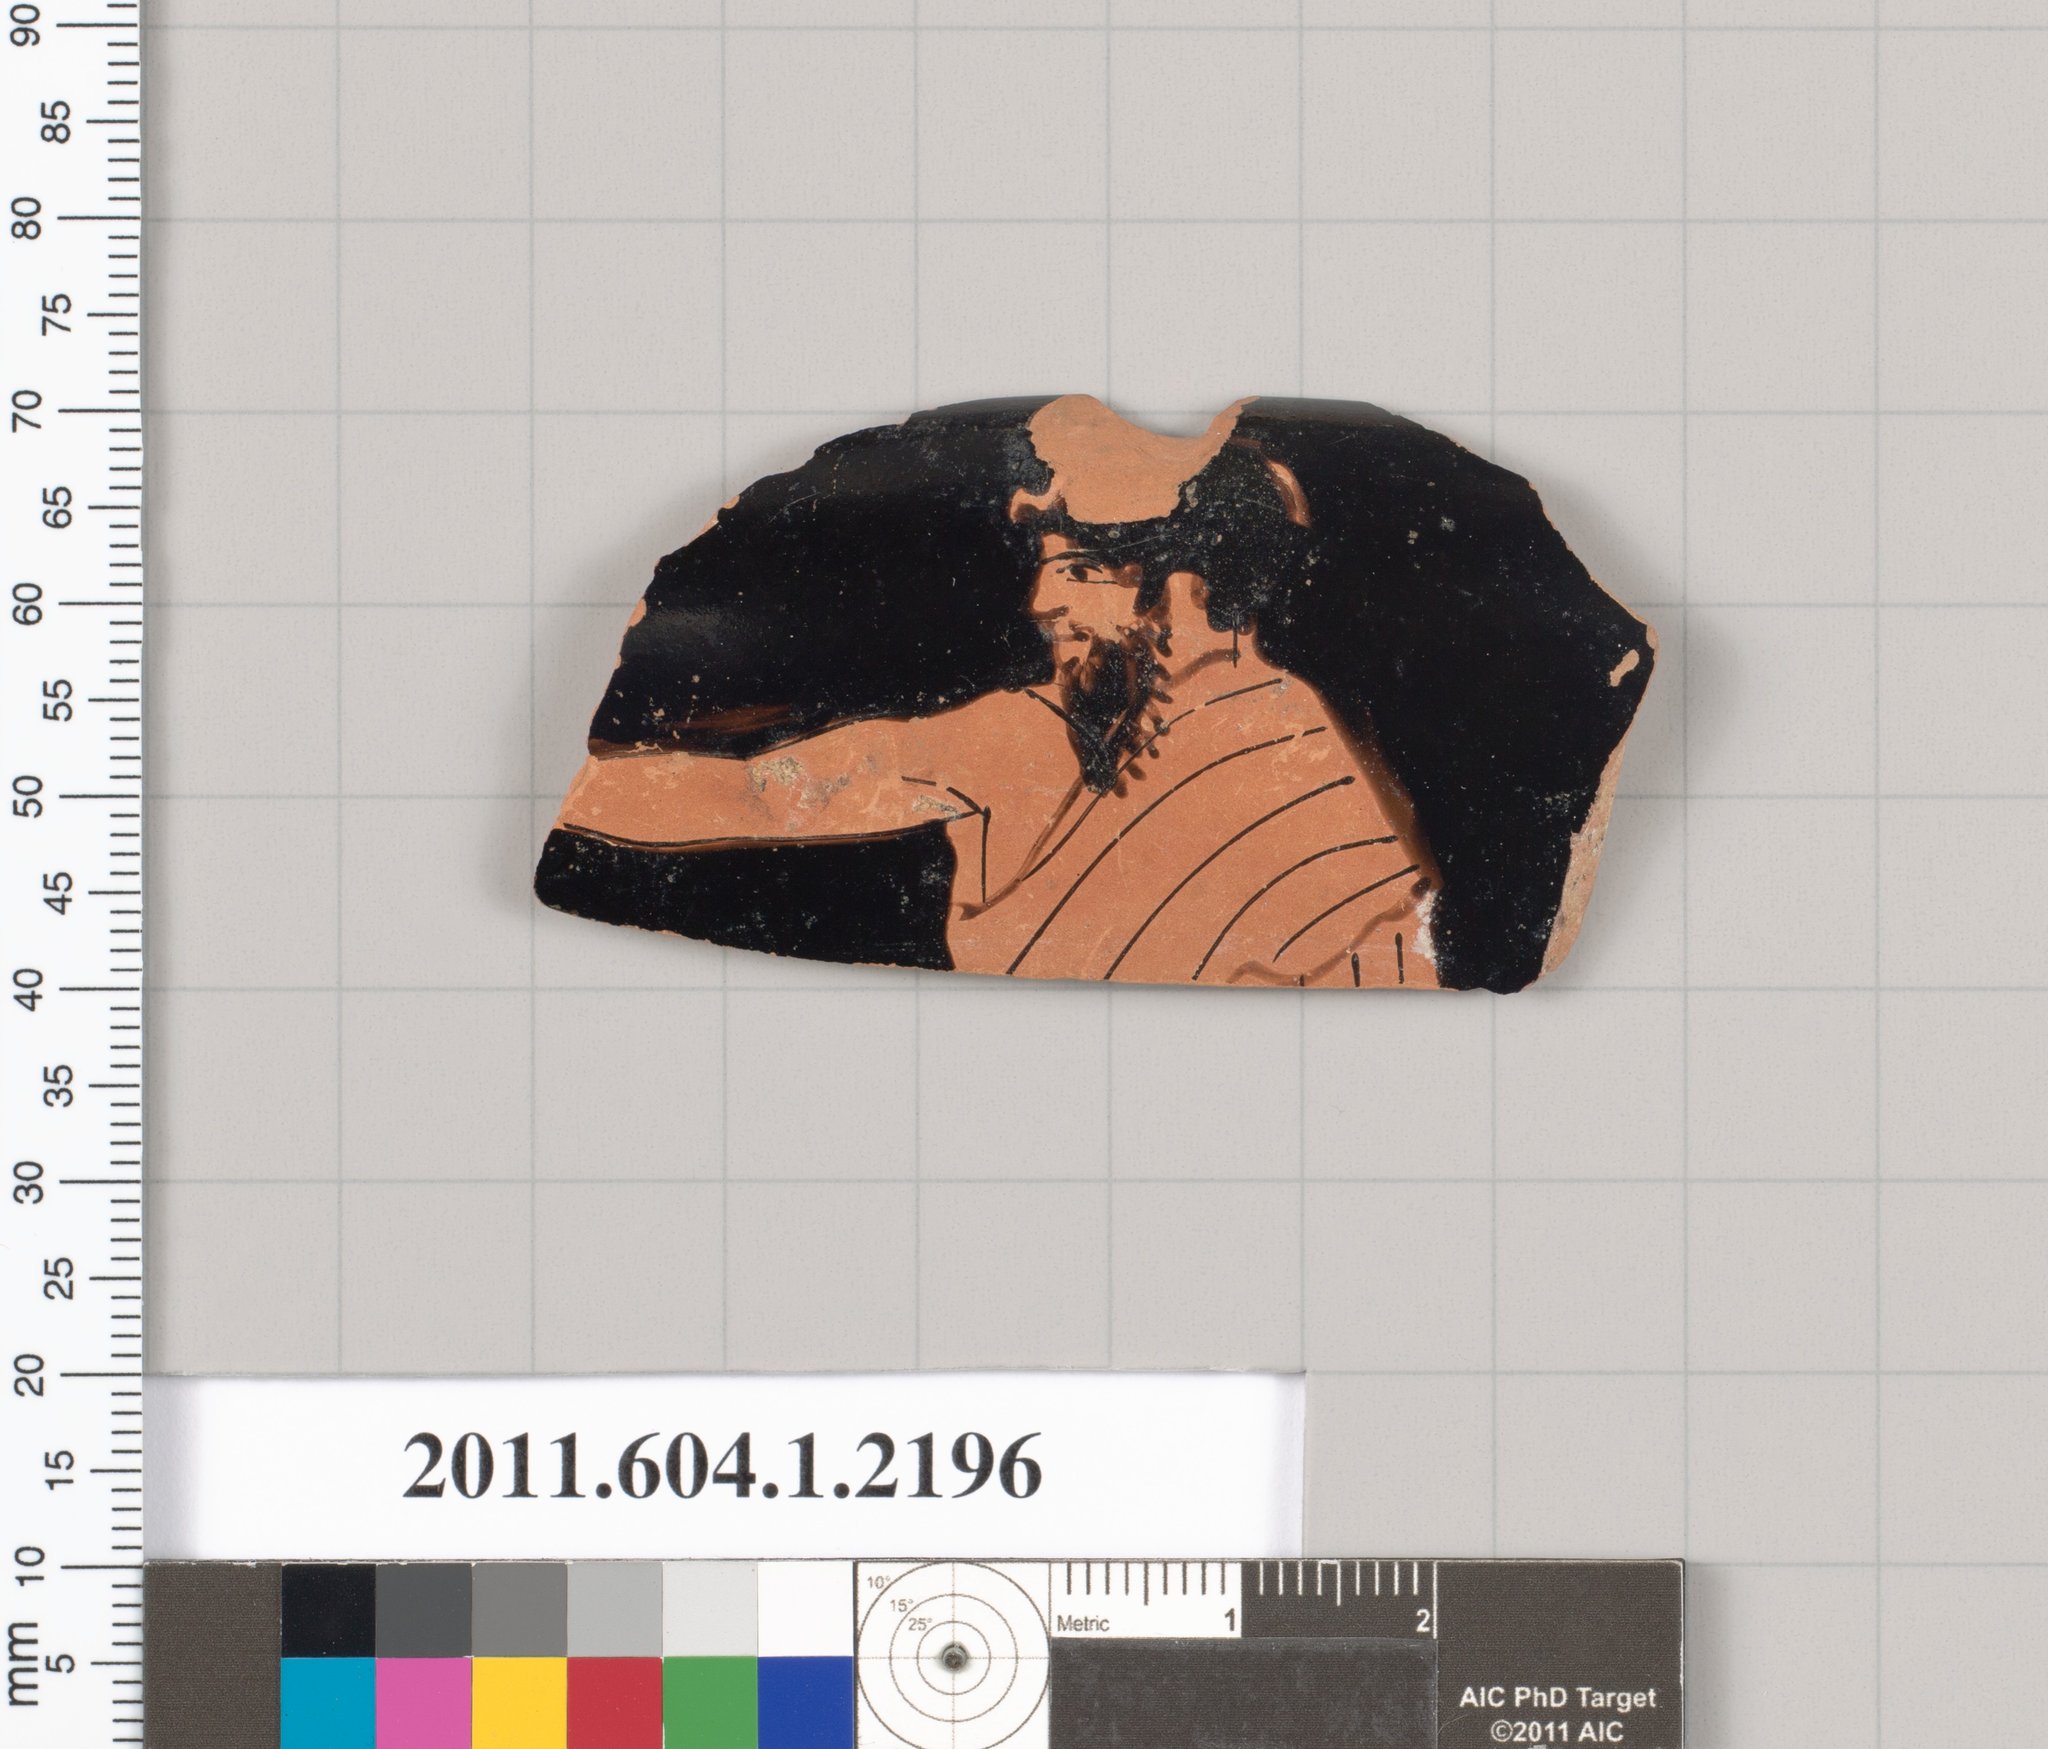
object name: kylix fragment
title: Terracotta rim fragment of a kylix (drinking cup)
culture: greek, attic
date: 467-435 BCE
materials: terracotta